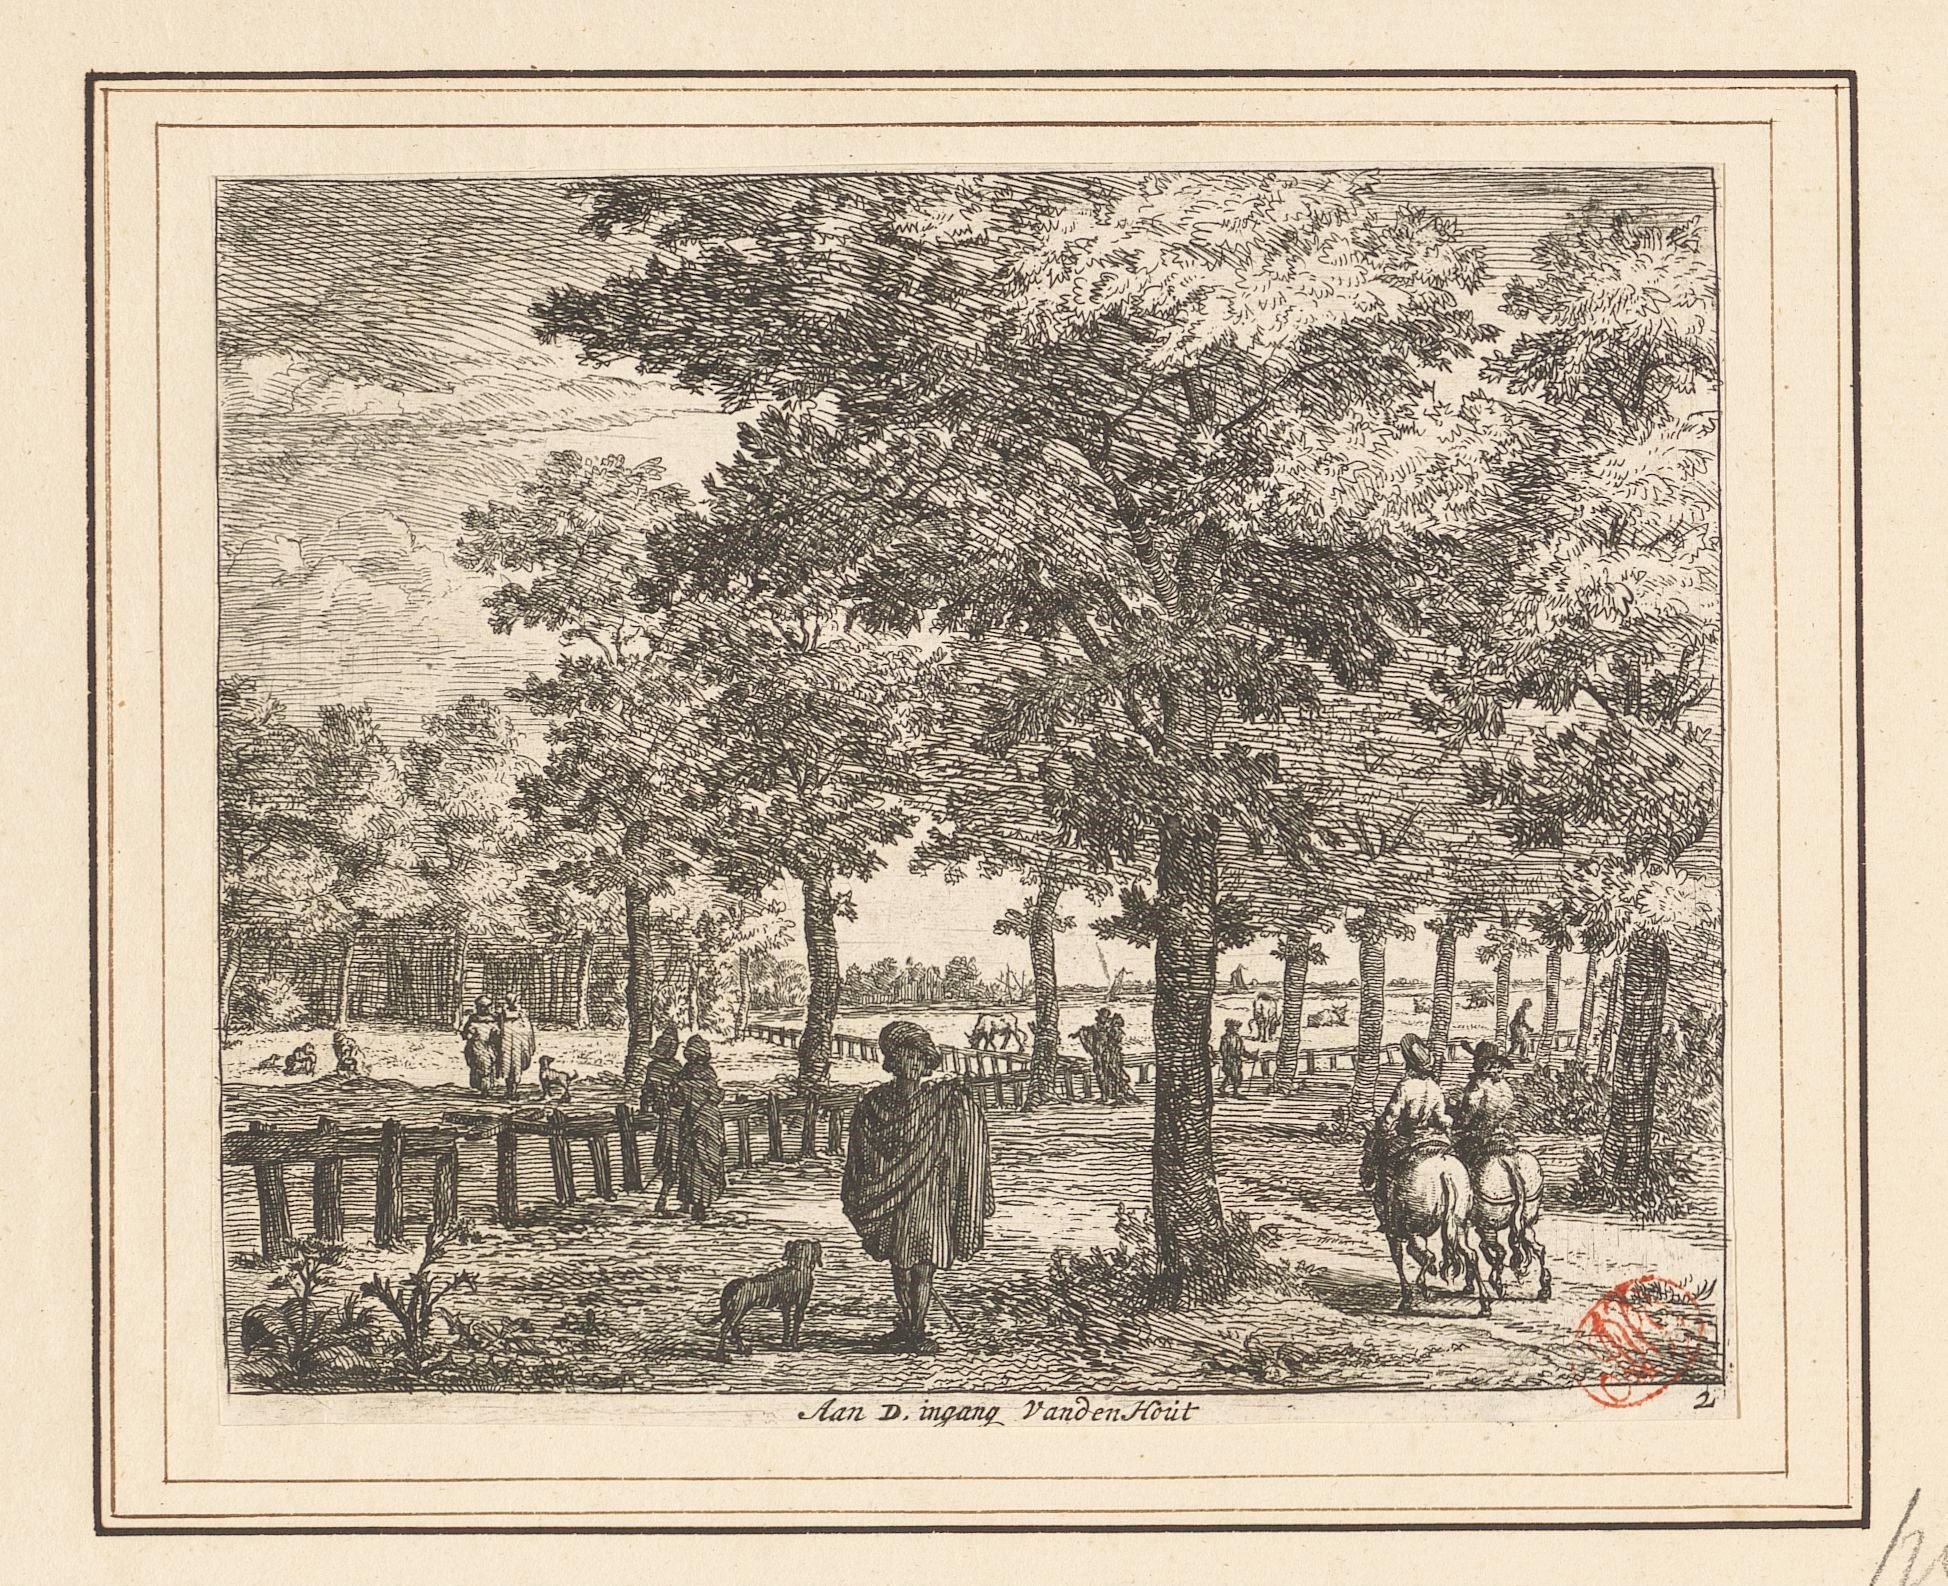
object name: print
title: Aan D. ingang vanden Hout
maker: jan vincentsz. van der vinne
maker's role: draughtsman, print maker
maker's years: 1663-1721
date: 1688-1690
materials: paper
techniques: etching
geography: haarlem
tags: riding a horse, ass, or mule; rider, horseman, walking, hiking (recreation), forest path or lane (+ landscape with figures, staffage), haarlem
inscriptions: collector's mark: Lugt 195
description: Wandelende figuren bij een laan met bomenrijen. Rechts twee ruiters. Rechtsonder genummerd: 2.